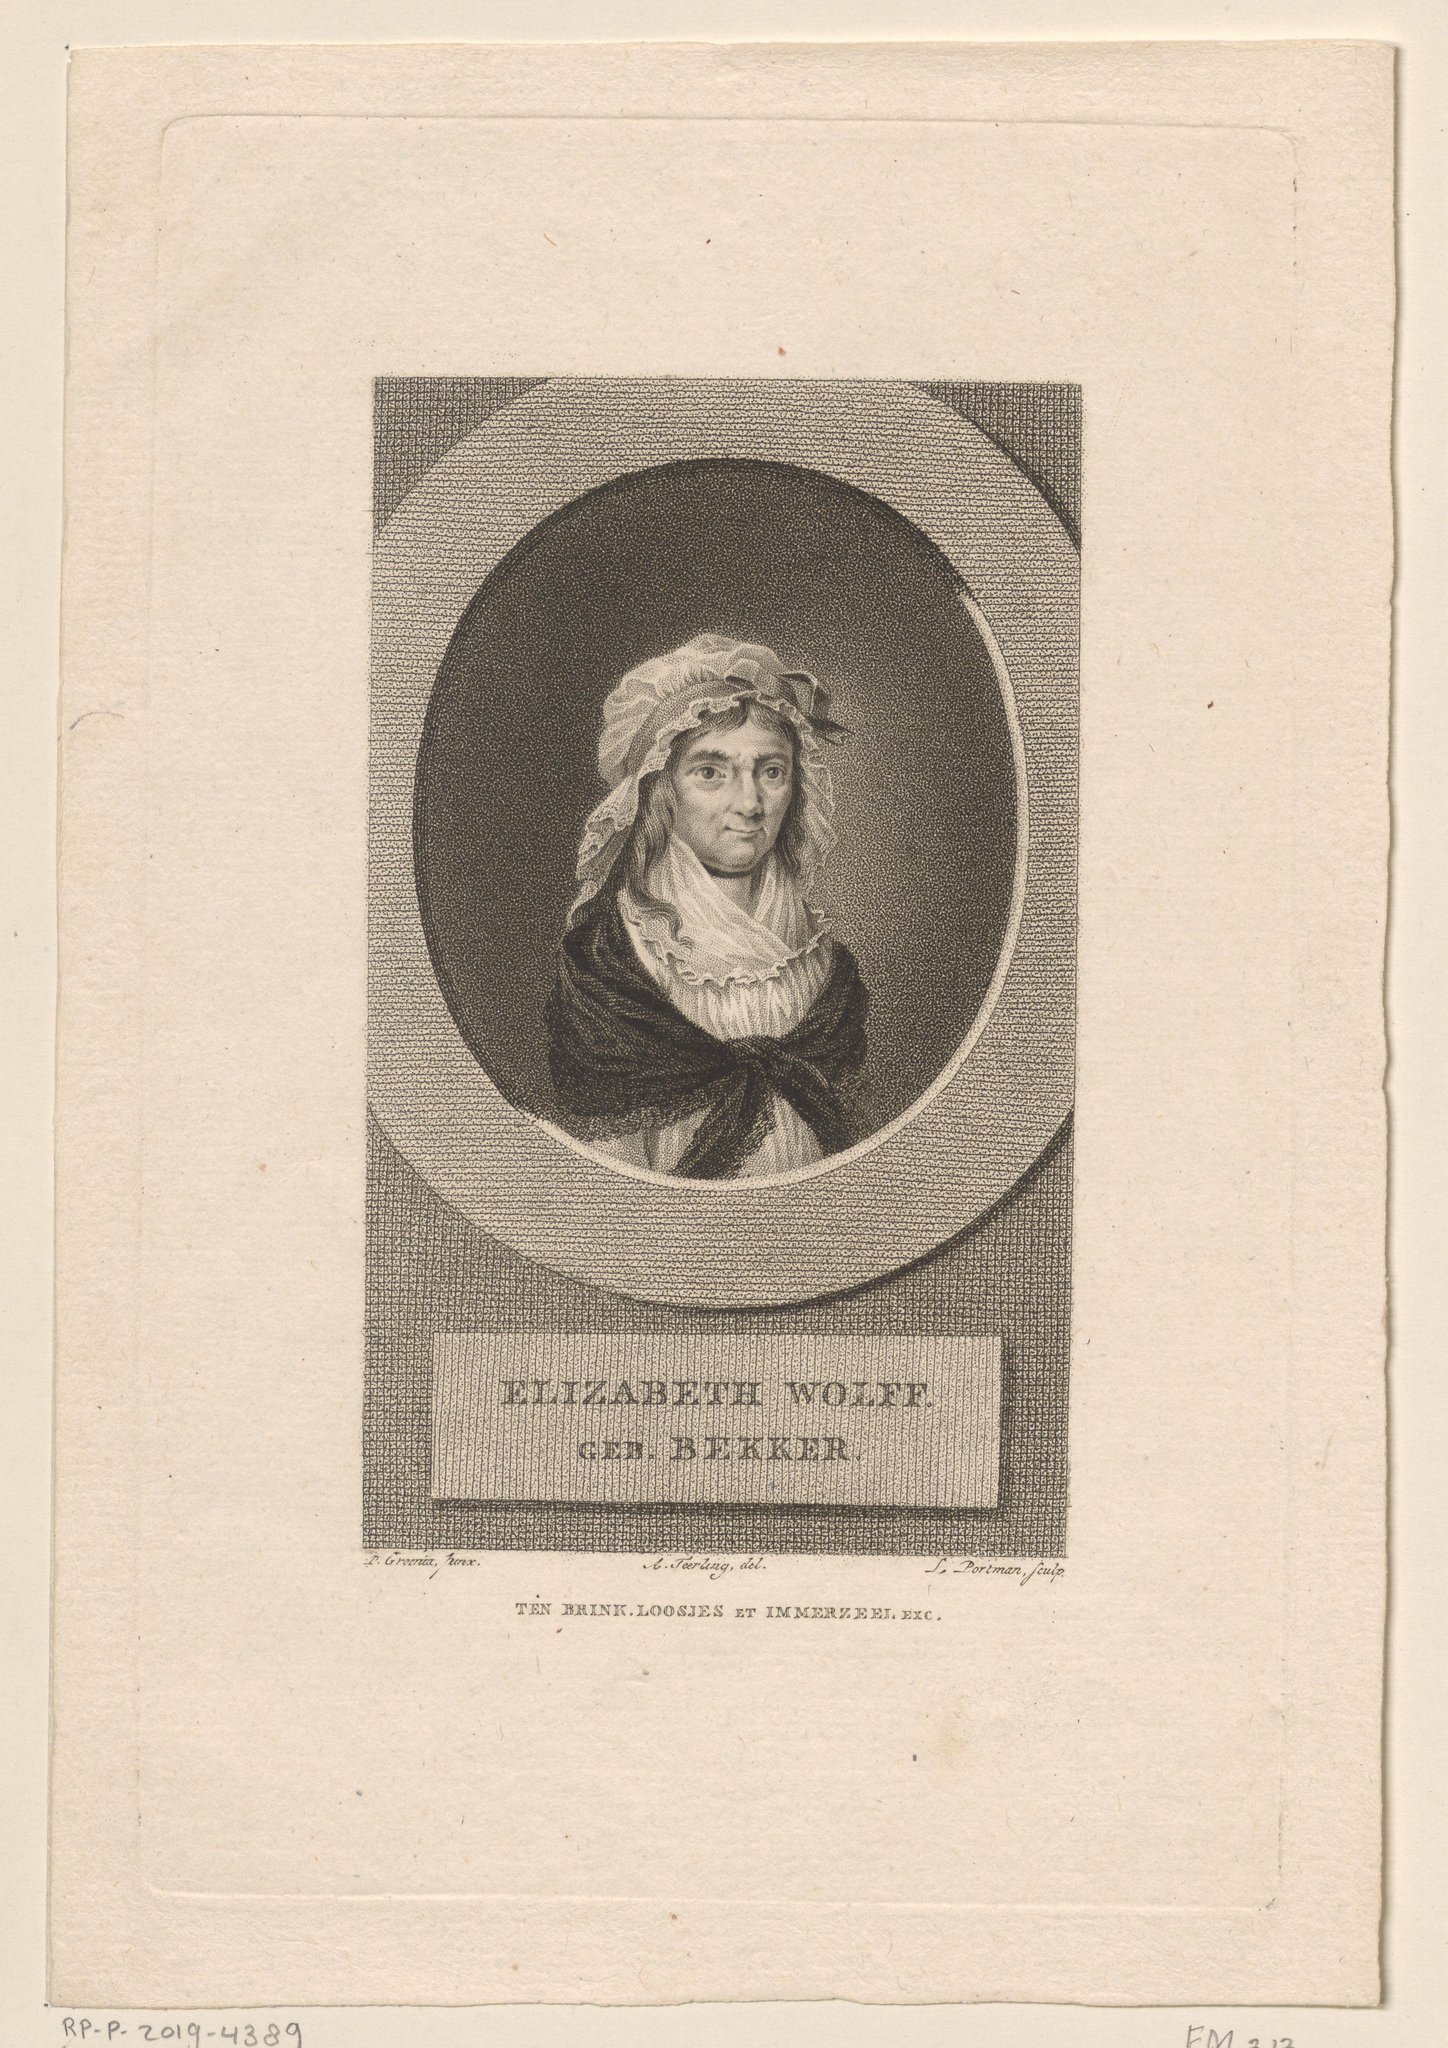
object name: print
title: Portret van Elisabeth Wolff-Bekker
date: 1805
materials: paper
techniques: etching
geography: amsterdam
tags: flushing, the hague, elisabeth bekker, historical persons - bb - woman, portrait of a writer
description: Bijgevoegd is een kort vers in boekdruk, 'op Elizabeth Wolff, geb. Bekker', door Adriaan Pietersz. Loosjes.